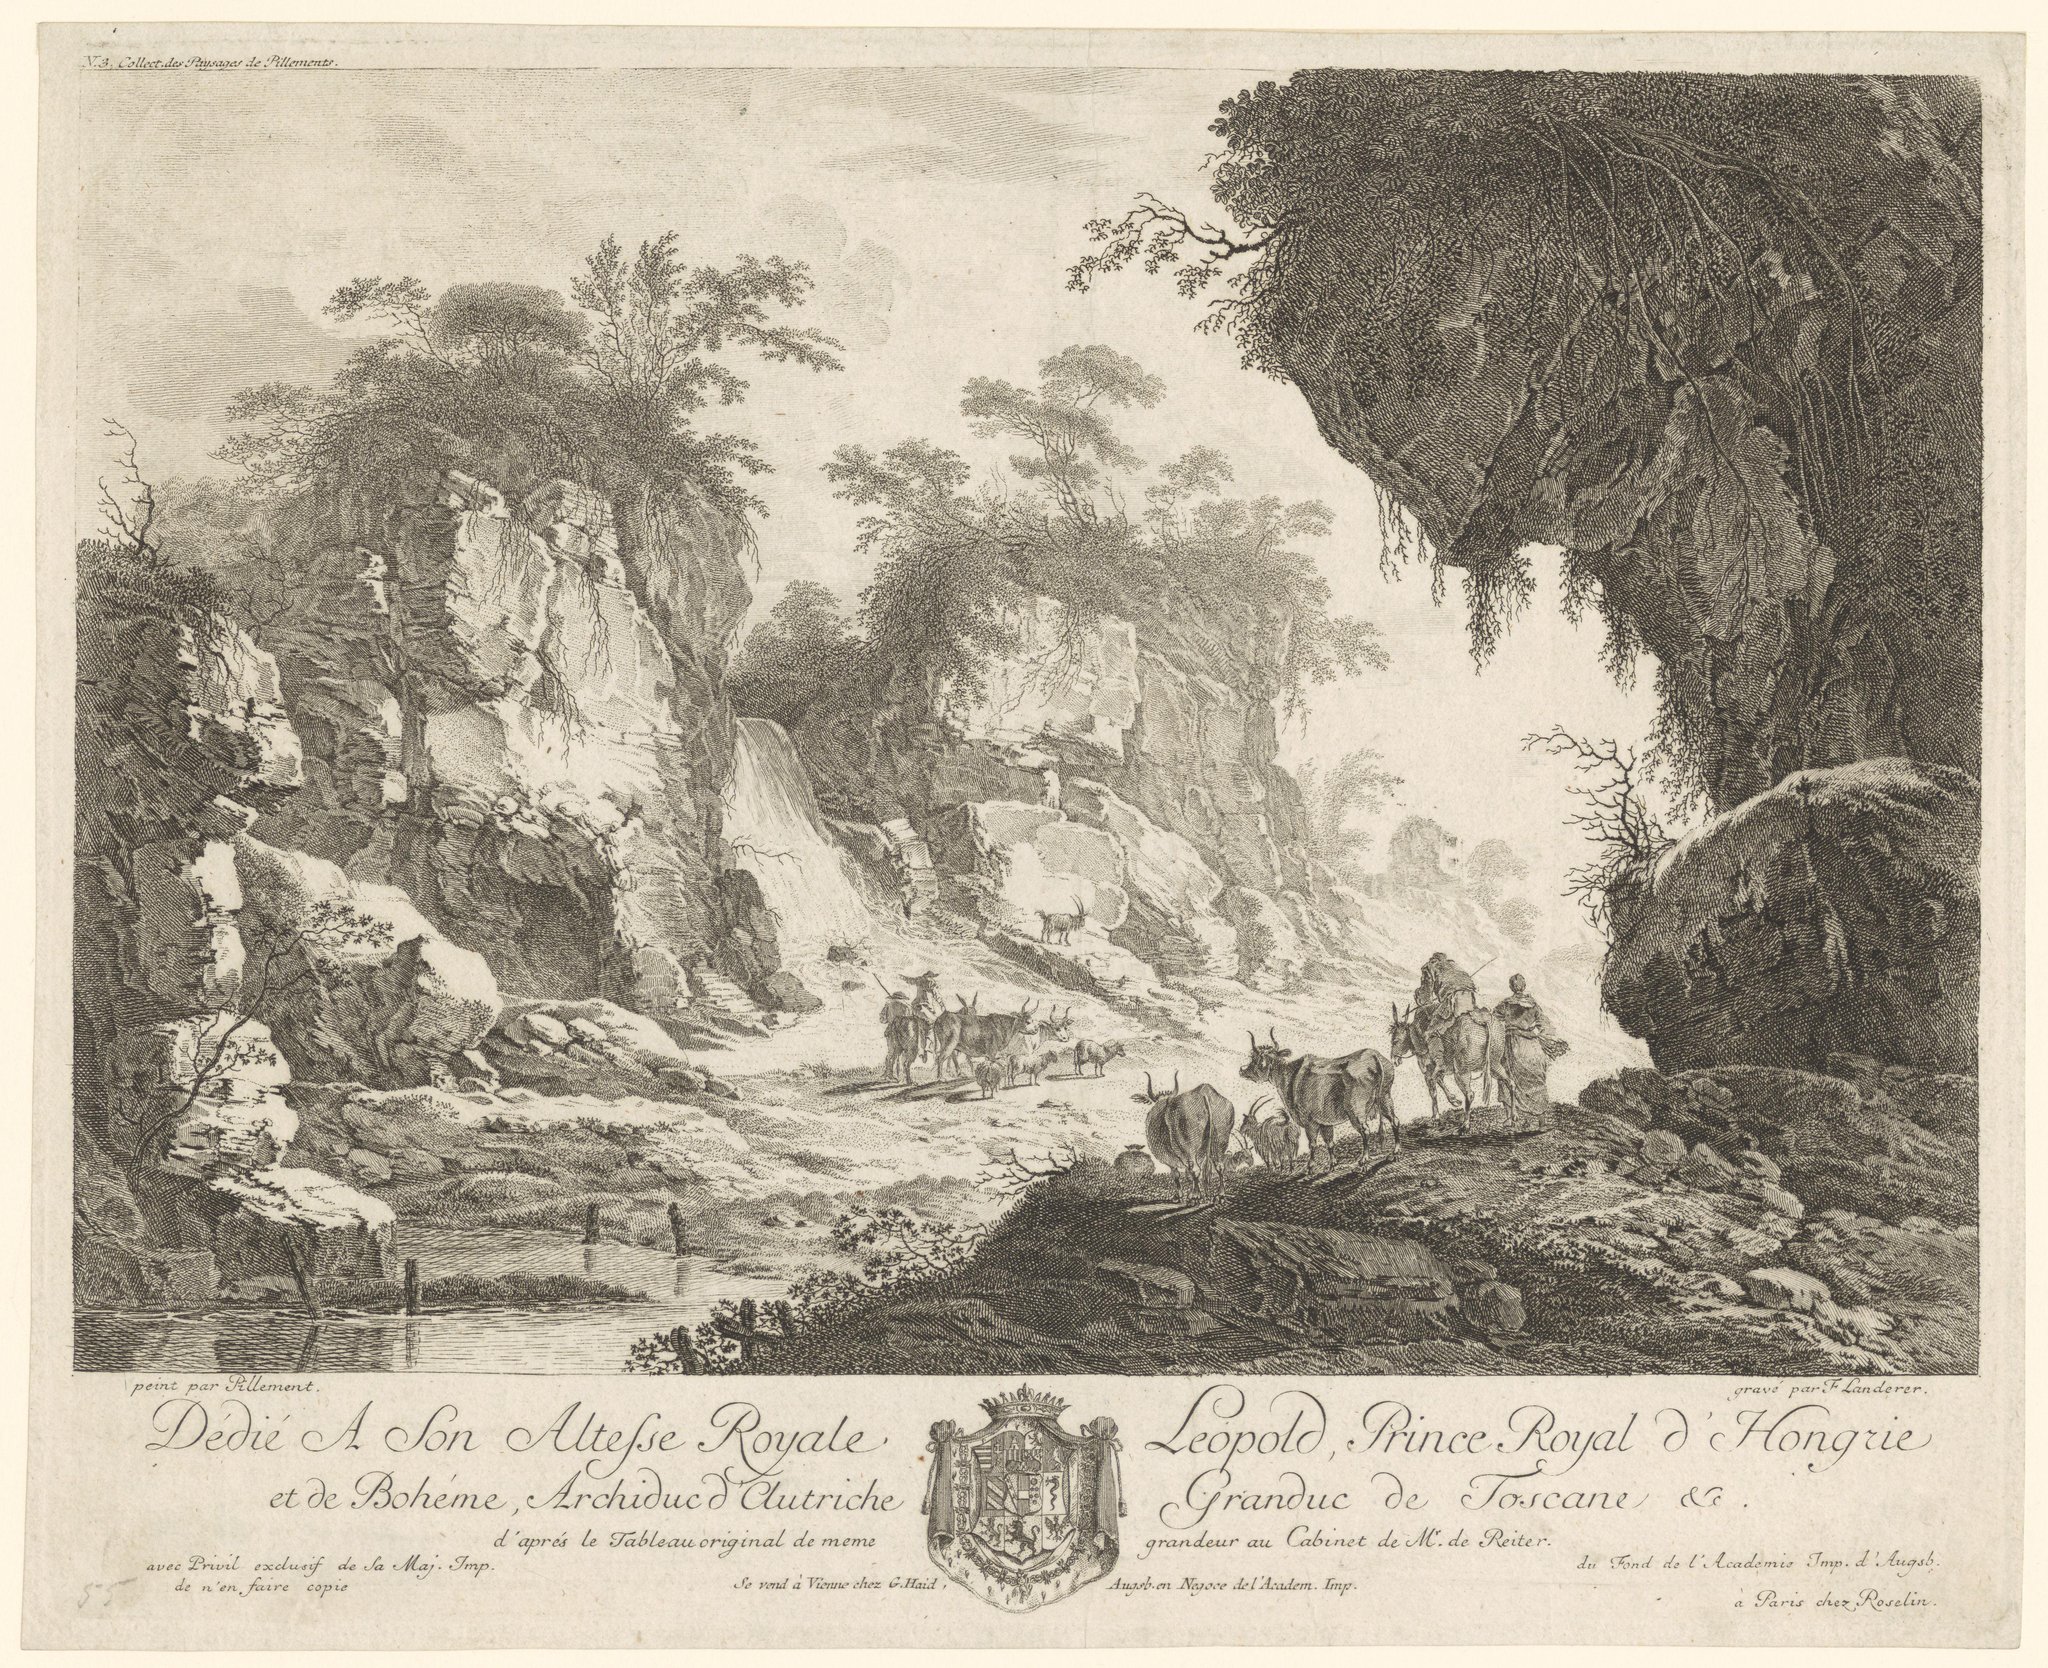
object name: print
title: Collection de Paysages de Pillement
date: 1763-1764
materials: paper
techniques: etching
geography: paris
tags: herding, herdsman, herdswoman, shepherd, shepherdess, cowherd, etc., (high) hill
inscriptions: collector's mark: Lugt 2228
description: Deze prent maakt deel uit van een serie van acht prenten met landschappen.